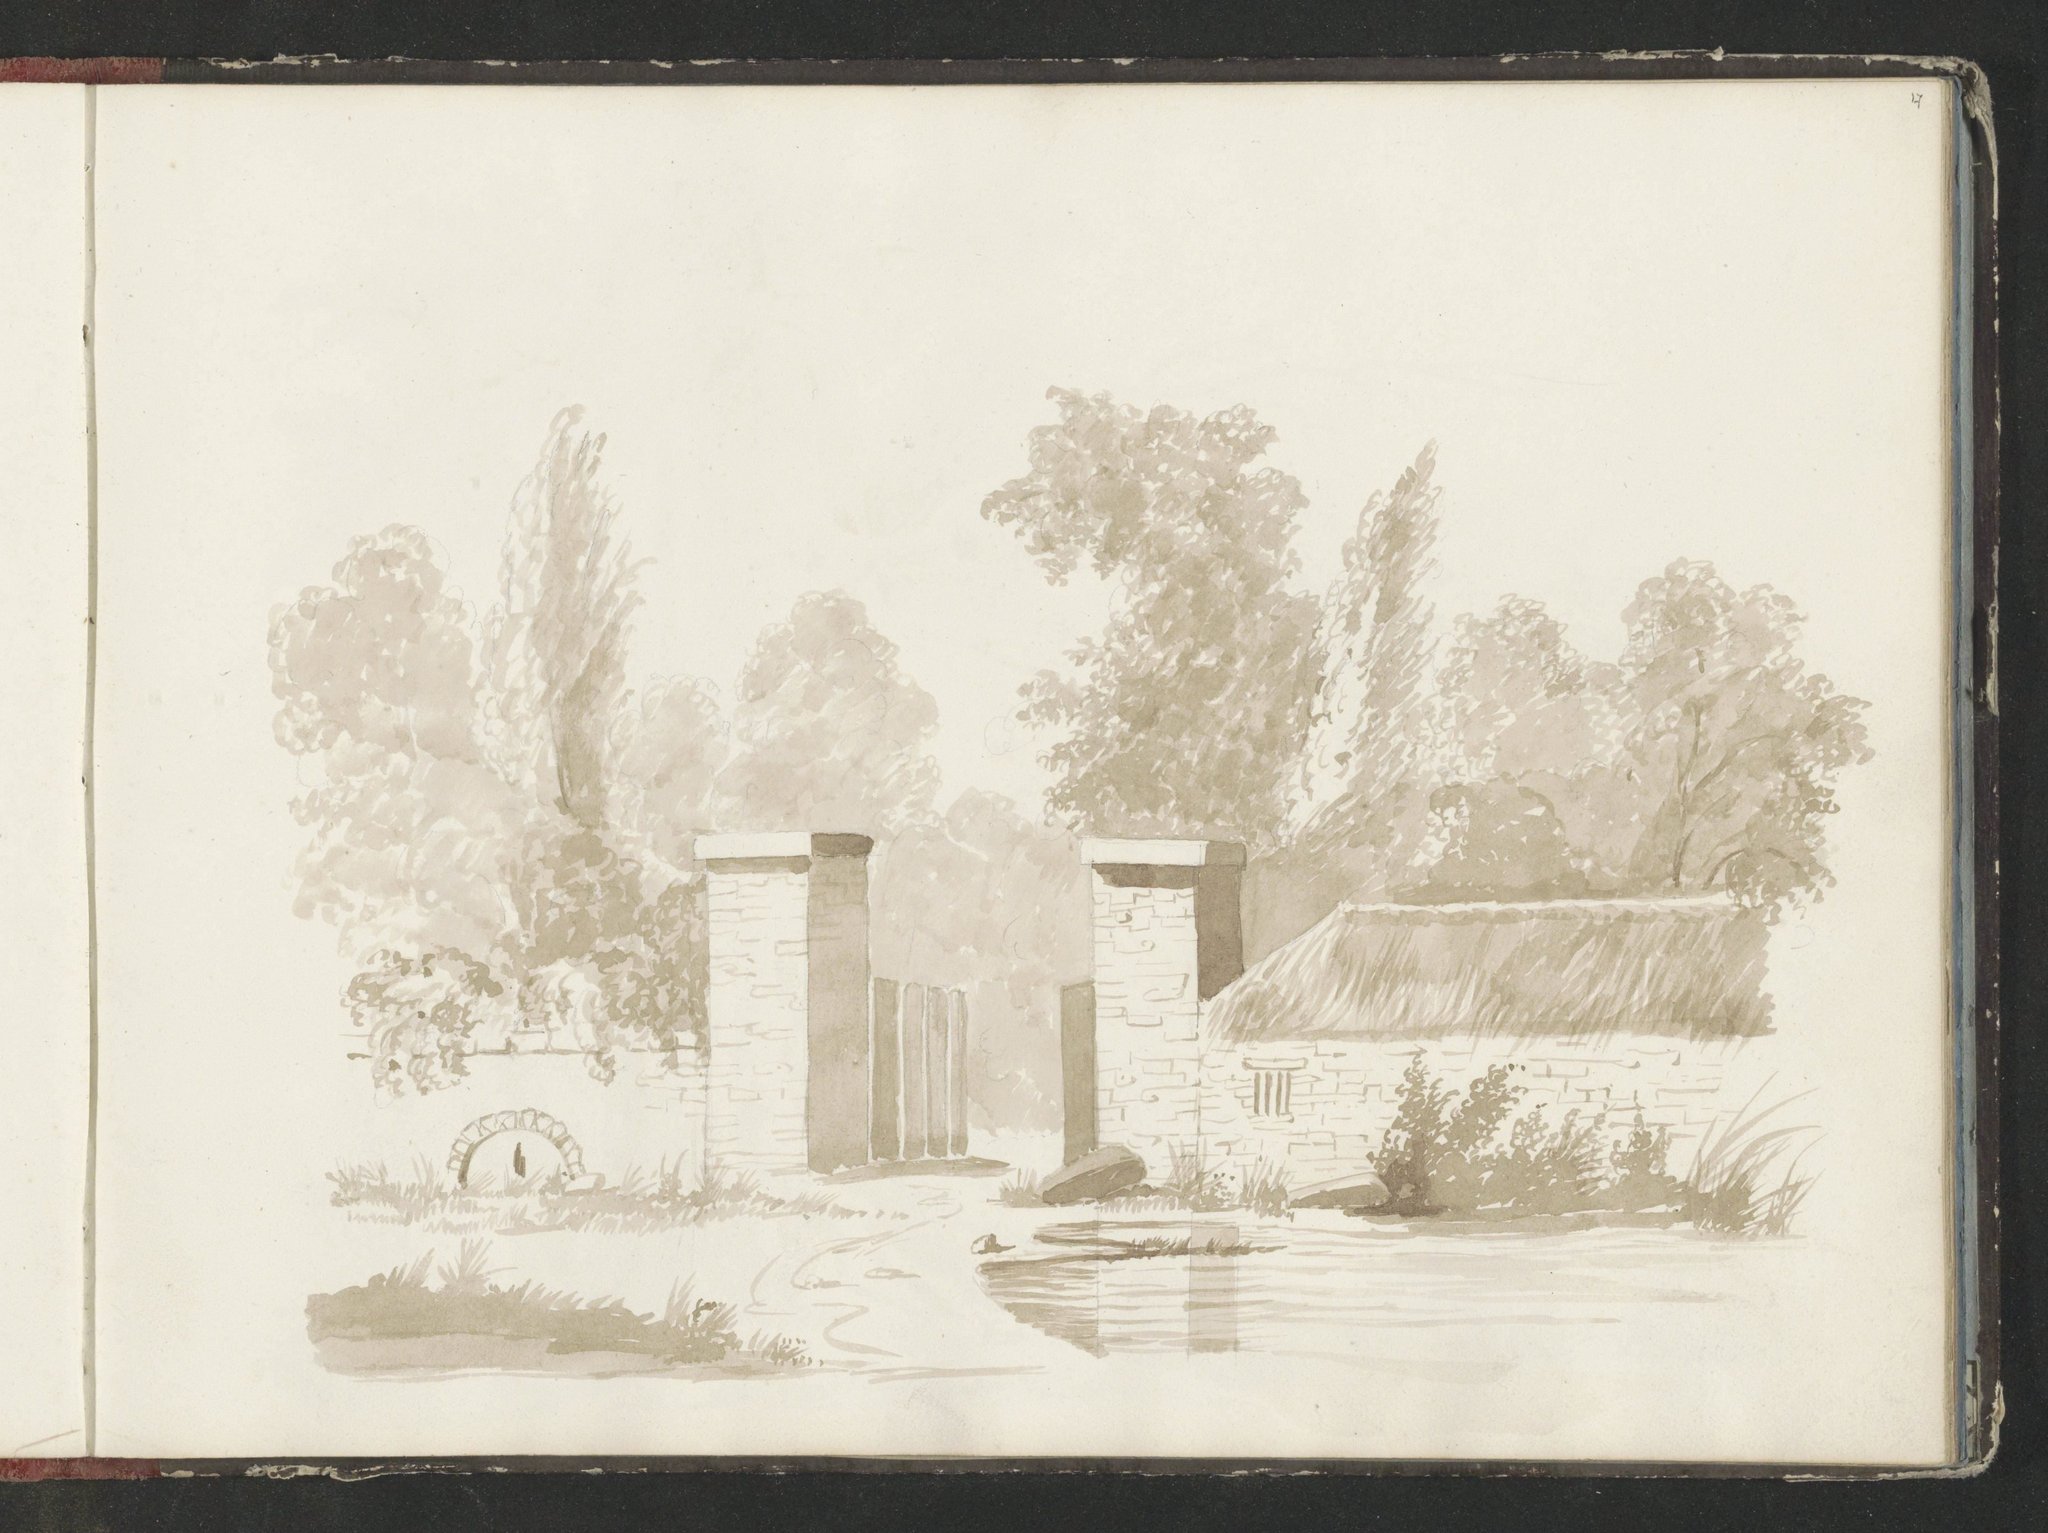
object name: sketchbook leaf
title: Toegangspoort bij een pad langs een waterkant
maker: Anonymous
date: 1819-1870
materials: ink, paper, pencil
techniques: brush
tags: landscapes with waters, waterscapes, seascapes (in the temperate zone), gate, entrance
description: Blad 17 recto uit een schetsboek met 39 bladen.